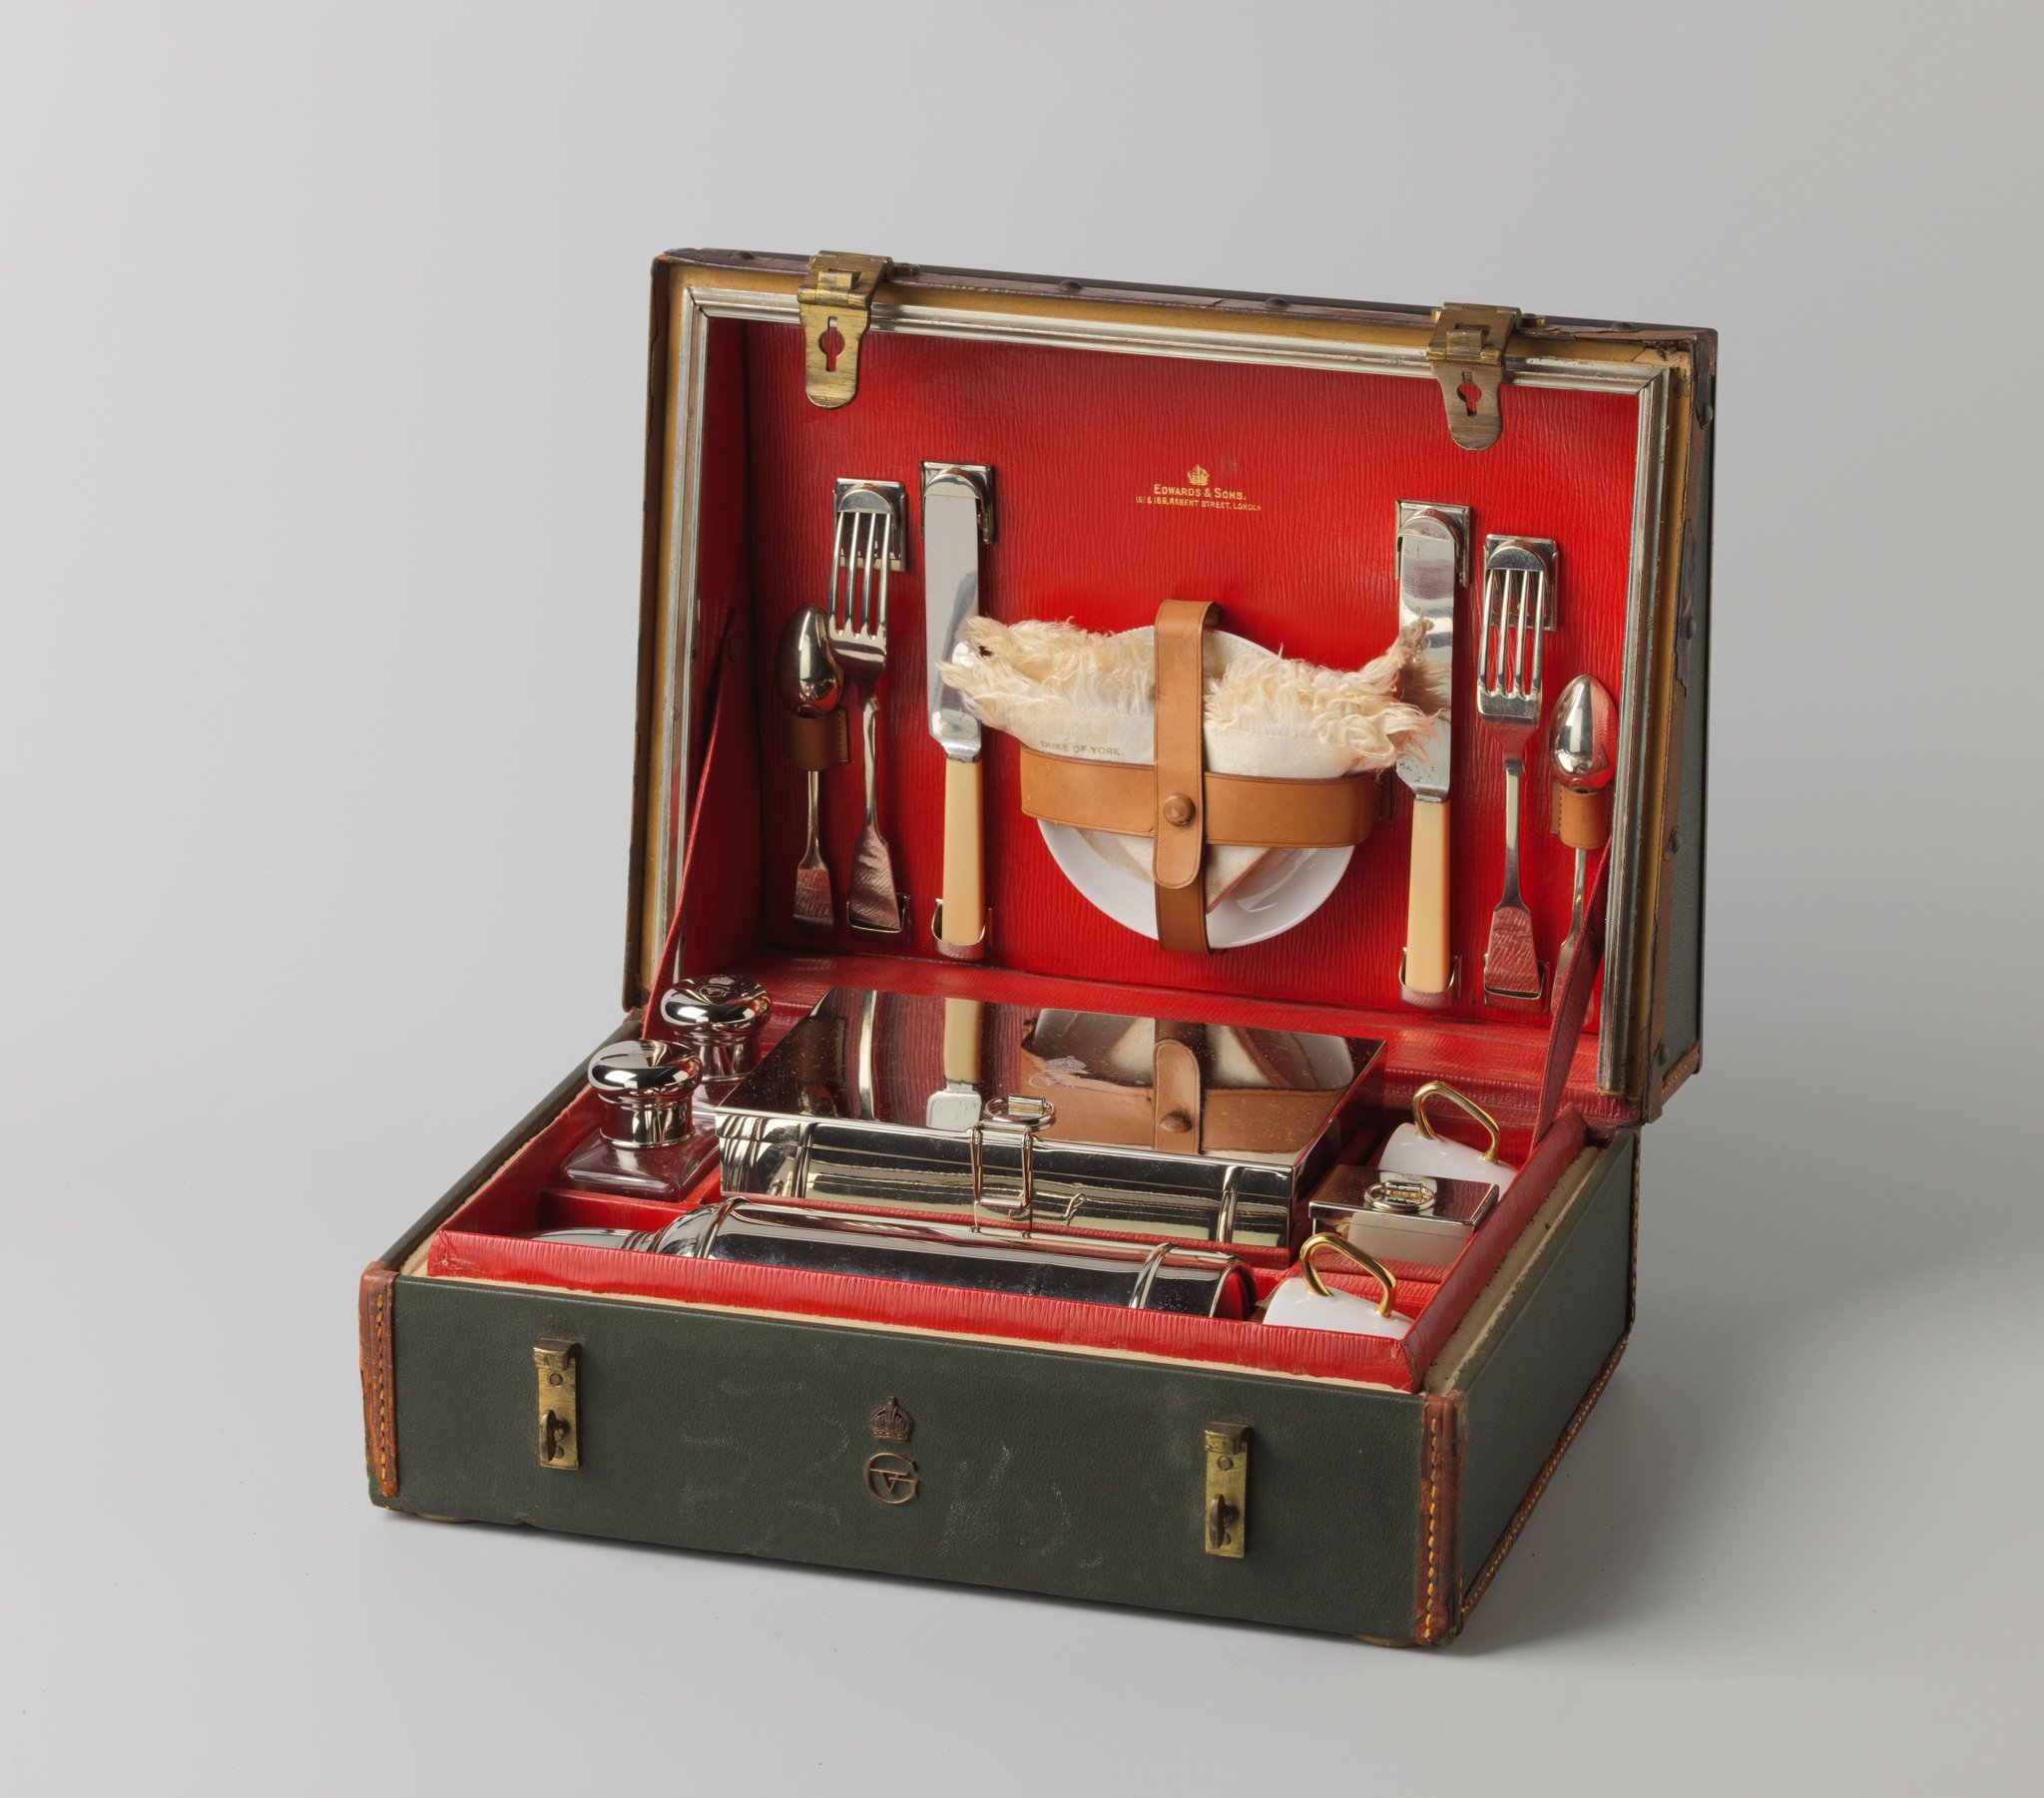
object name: reisnecessaire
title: Reisnecessaire met picnicset met monogram van Koning George V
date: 1920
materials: iron, leather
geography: london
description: De vorm van de groen lederen kist is “wedge shaped”. Aan de voorkant de initialen van Koning George V. De kist is van binnen gevoerd met rood leer, in gouden letters de gekroonde inscriptie: Edwards and Sons, 161 & 169 Regent street London, Registered no 541104/5, English patent 18693/1909. De buitenbovenkant van de deksel is bekleed met een ijzeren plaat die fungeert als voetenbankje. Inhoud: thermoskan, rechthoekige sandwichdoos met hengsel, rechthoekig doosje met hengsel, twee glazen flacons met chromen schroefdoppen, twee theelepels, twee vorken, twee messen, twee cilindervormige doosjes, waarvan één met porseleinen binnen-bakje, alle van chroom met gekroonde initialen van koning George V (1865-1936); twee witte porseleinen kopjes en één schoteltje, twee rechthoekige bordjes, twee linnen servetjes met tekst Duke of York travelling.